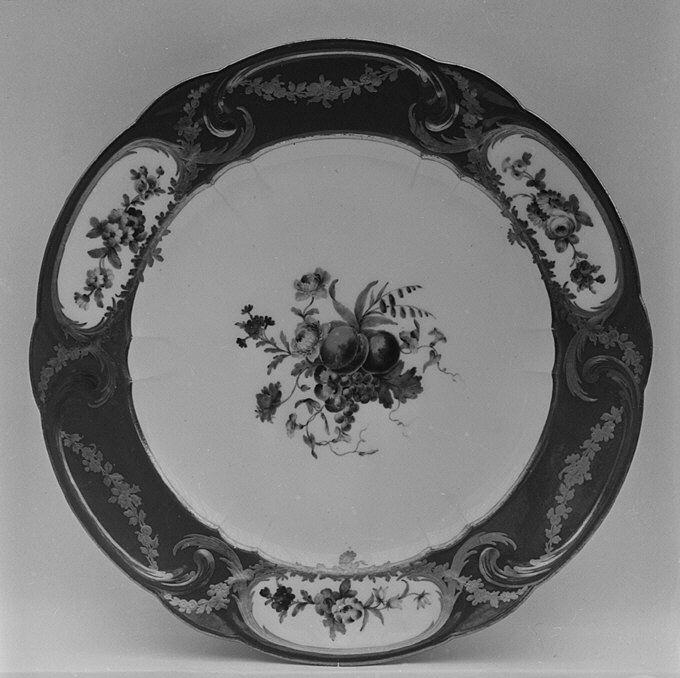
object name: plate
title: Plate (Assiette à palmes) (1 of 102) (part of a service)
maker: sèvres manufactory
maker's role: manufactory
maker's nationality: french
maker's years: 1740-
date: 1780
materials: soft paste porcelain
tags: flowers